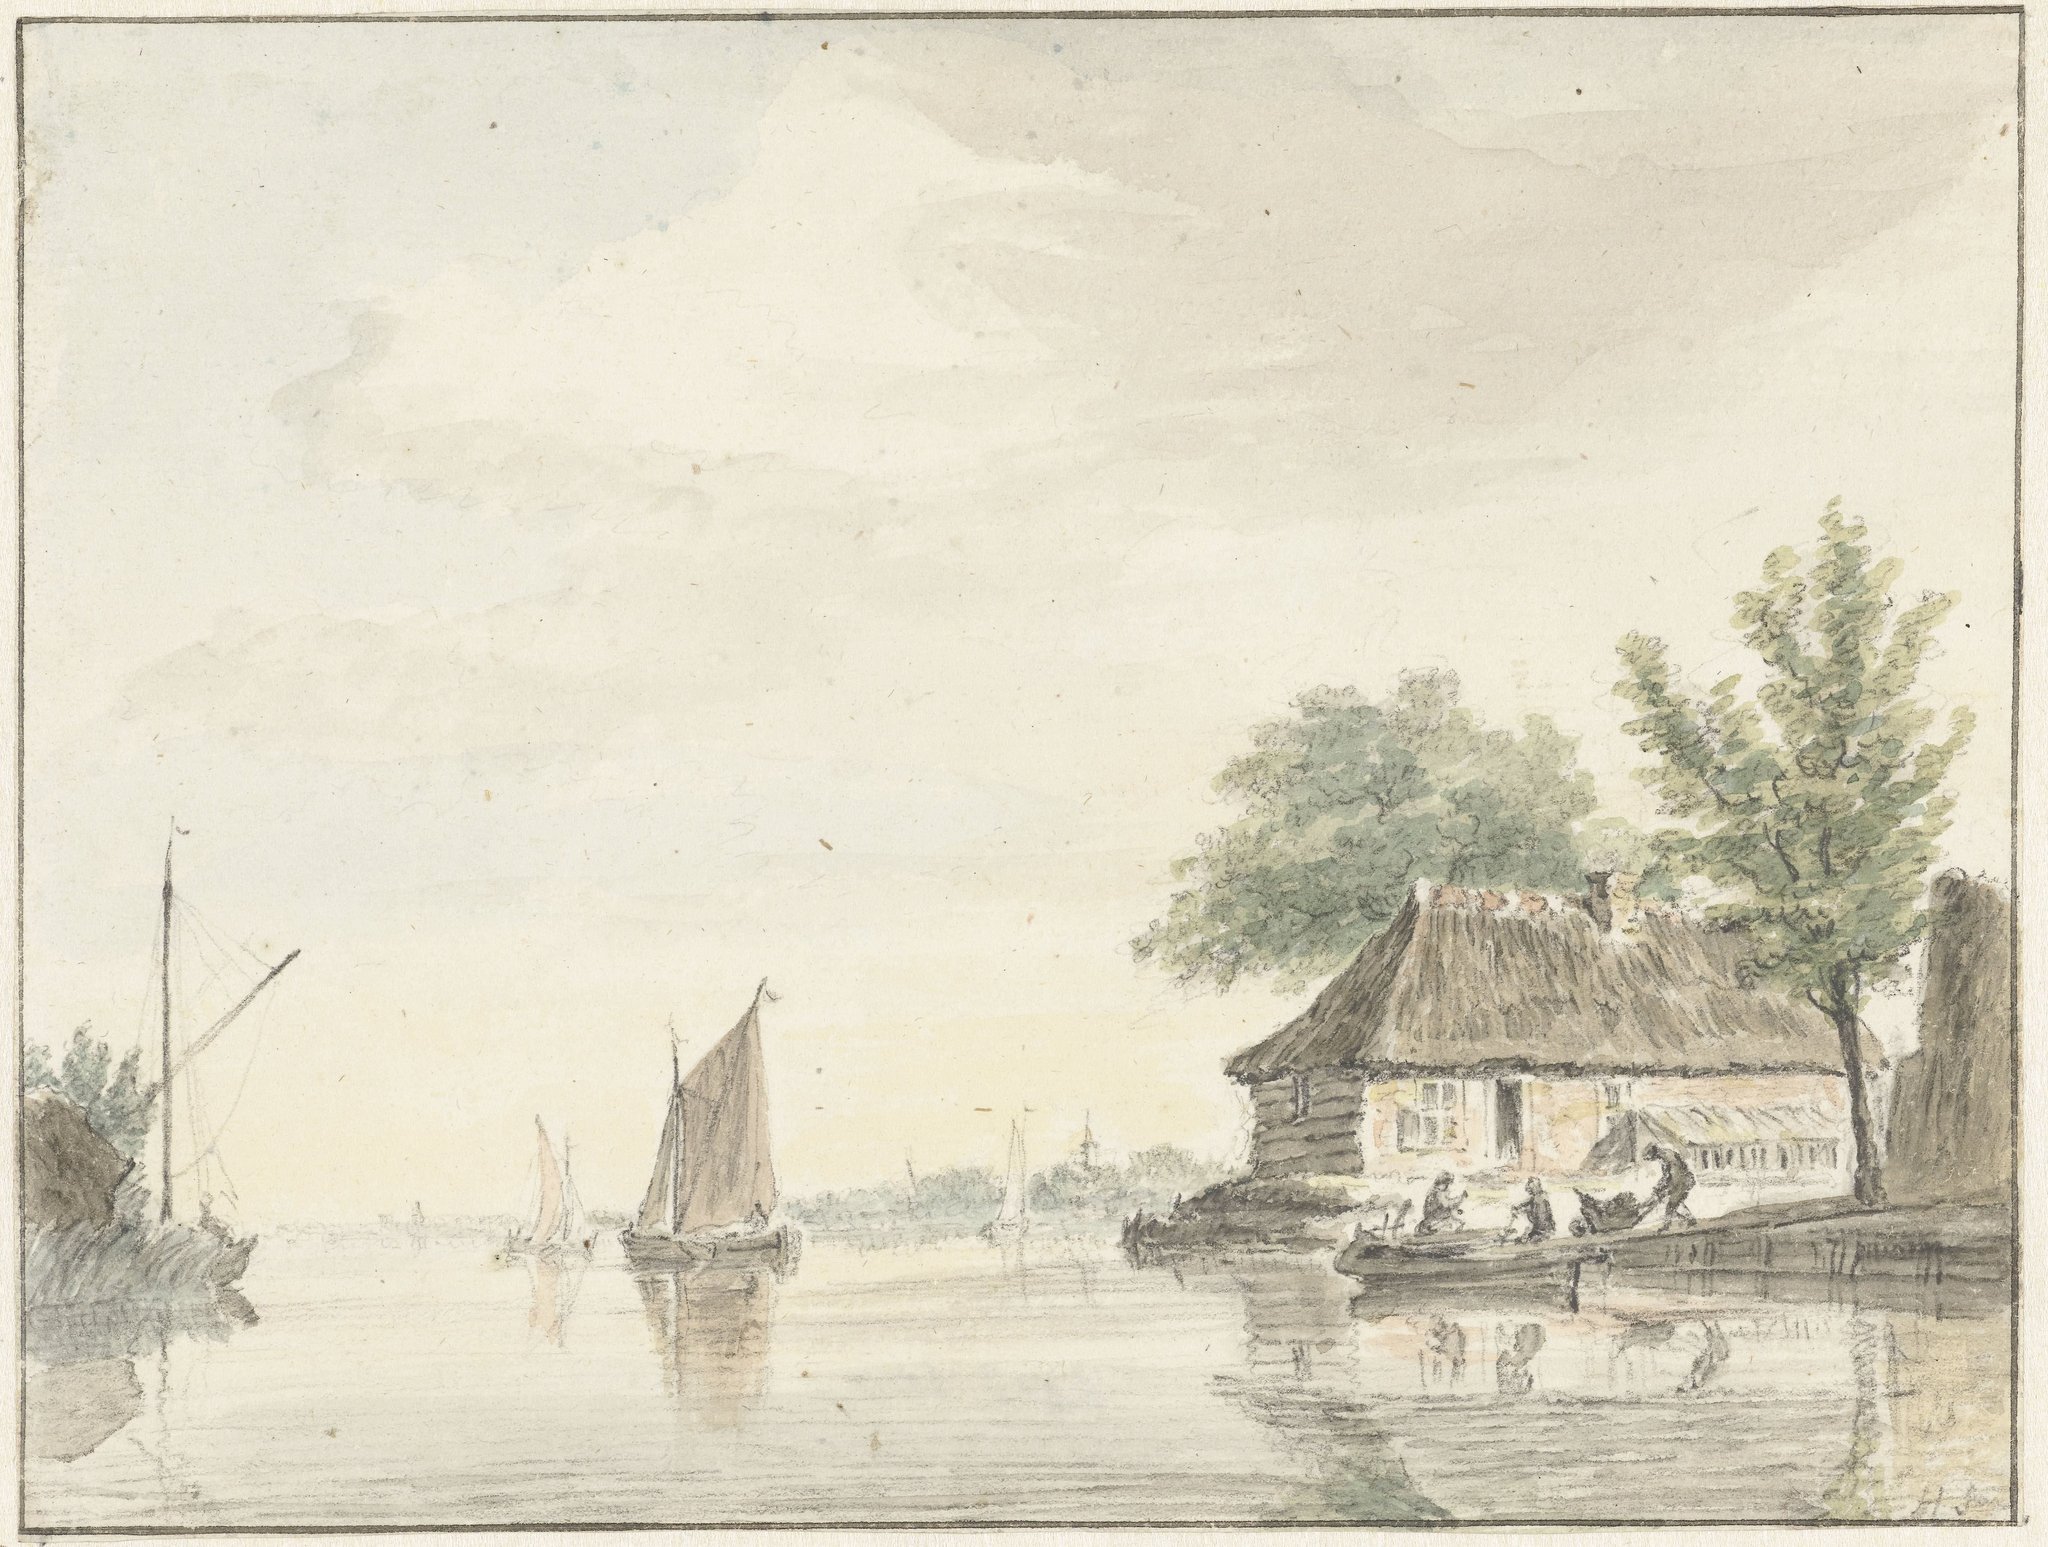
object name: drawing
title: Rivierlandschap met zeilende boten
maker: hendrik spilman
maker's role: draughtsman, painter, print maker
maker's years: 1721-1784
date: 1733-1784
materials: chalk, paper, watercolor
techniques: brush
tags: river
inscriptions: inscription: ‘H S (?)’